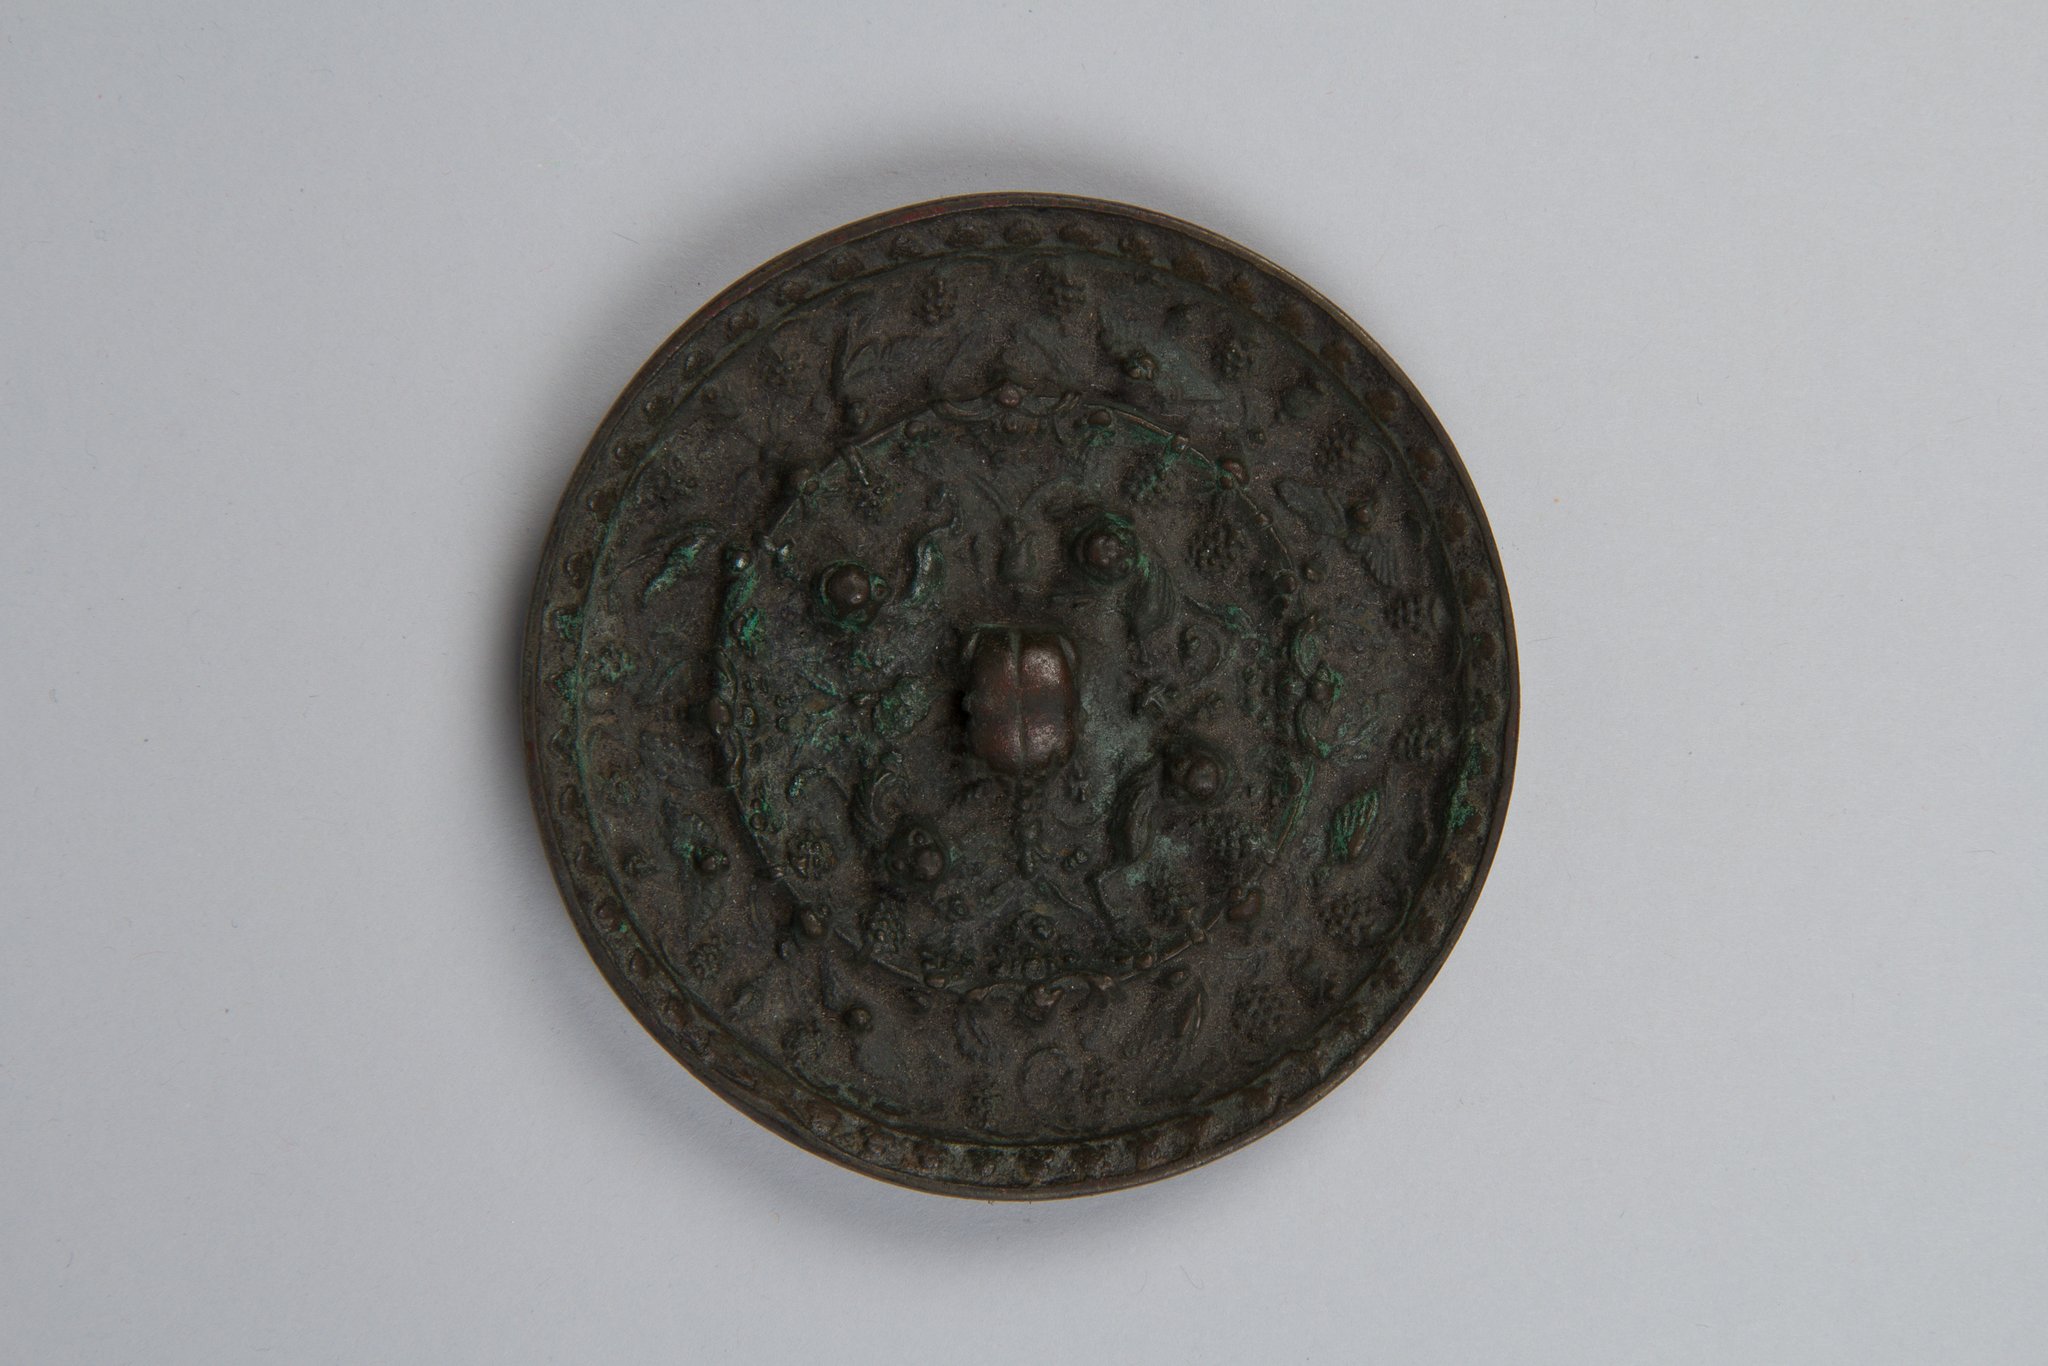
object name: mirror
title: Mirror with fantastic animals amid grape vines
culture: chinese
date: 601-800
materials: bronze